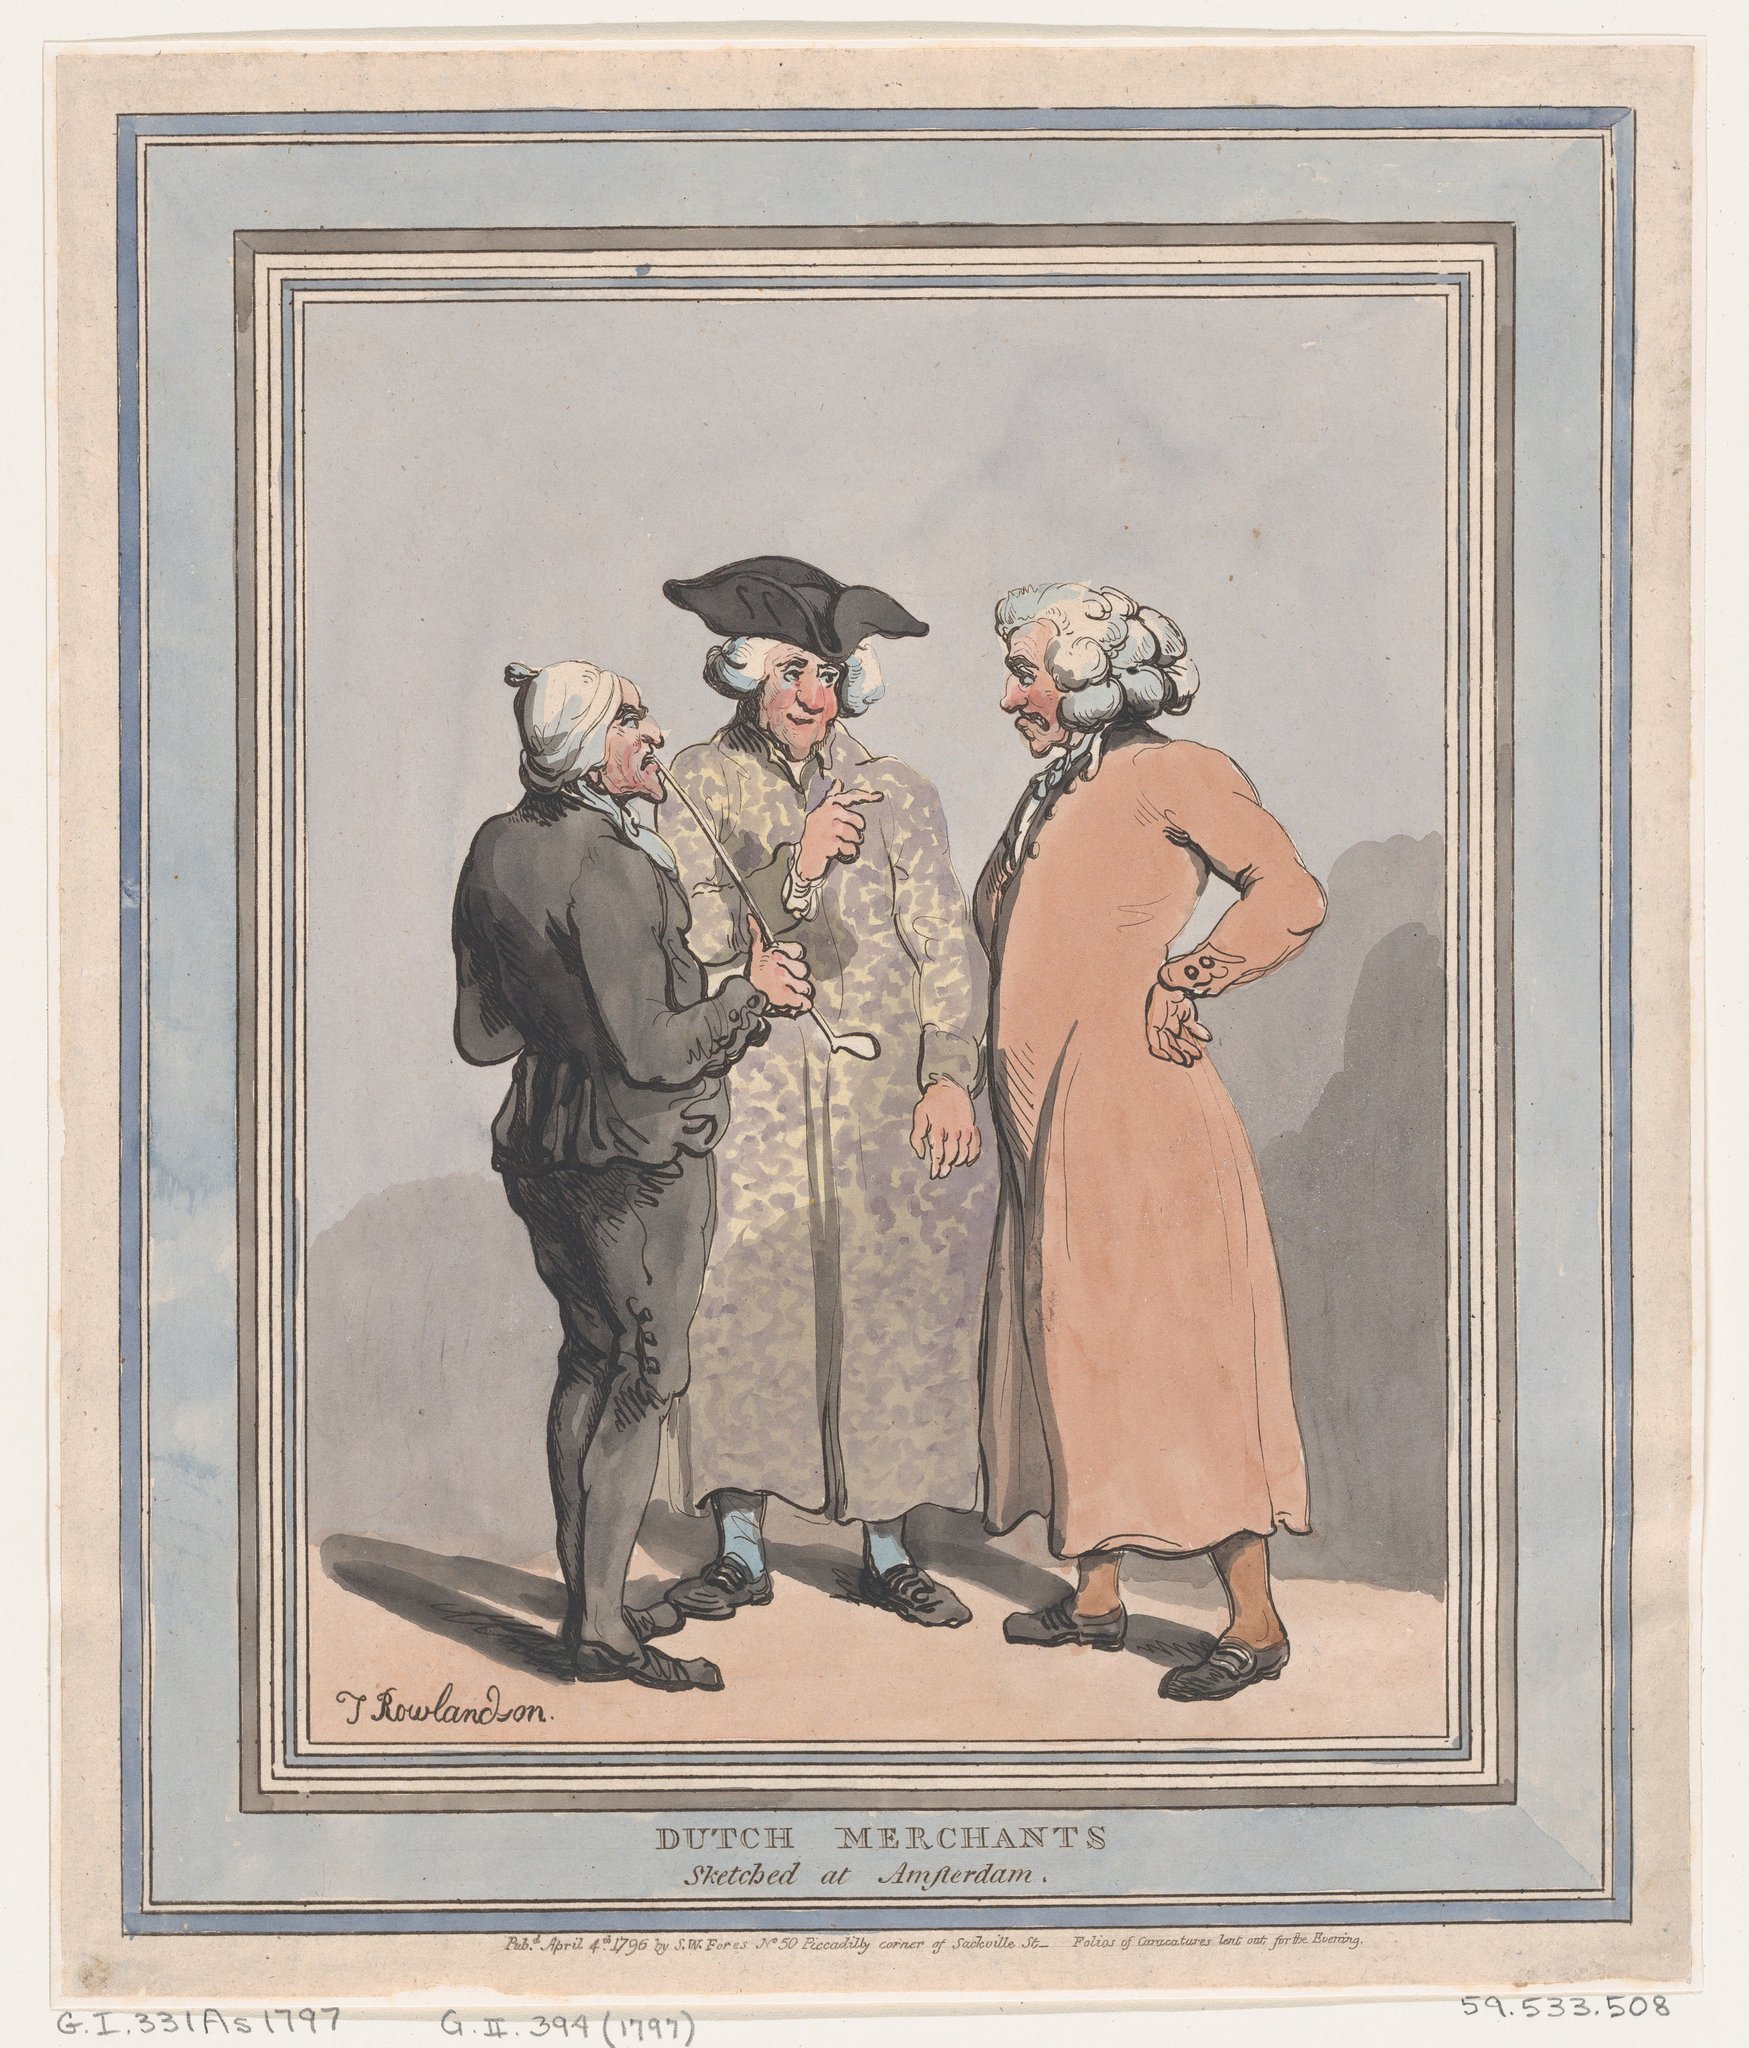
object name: print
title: Dutch Merchants Sketched at Amsterdam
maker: thomas rowlandson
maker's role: artist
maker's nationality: british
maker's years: 1757-1827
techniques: etching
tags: men,merchants